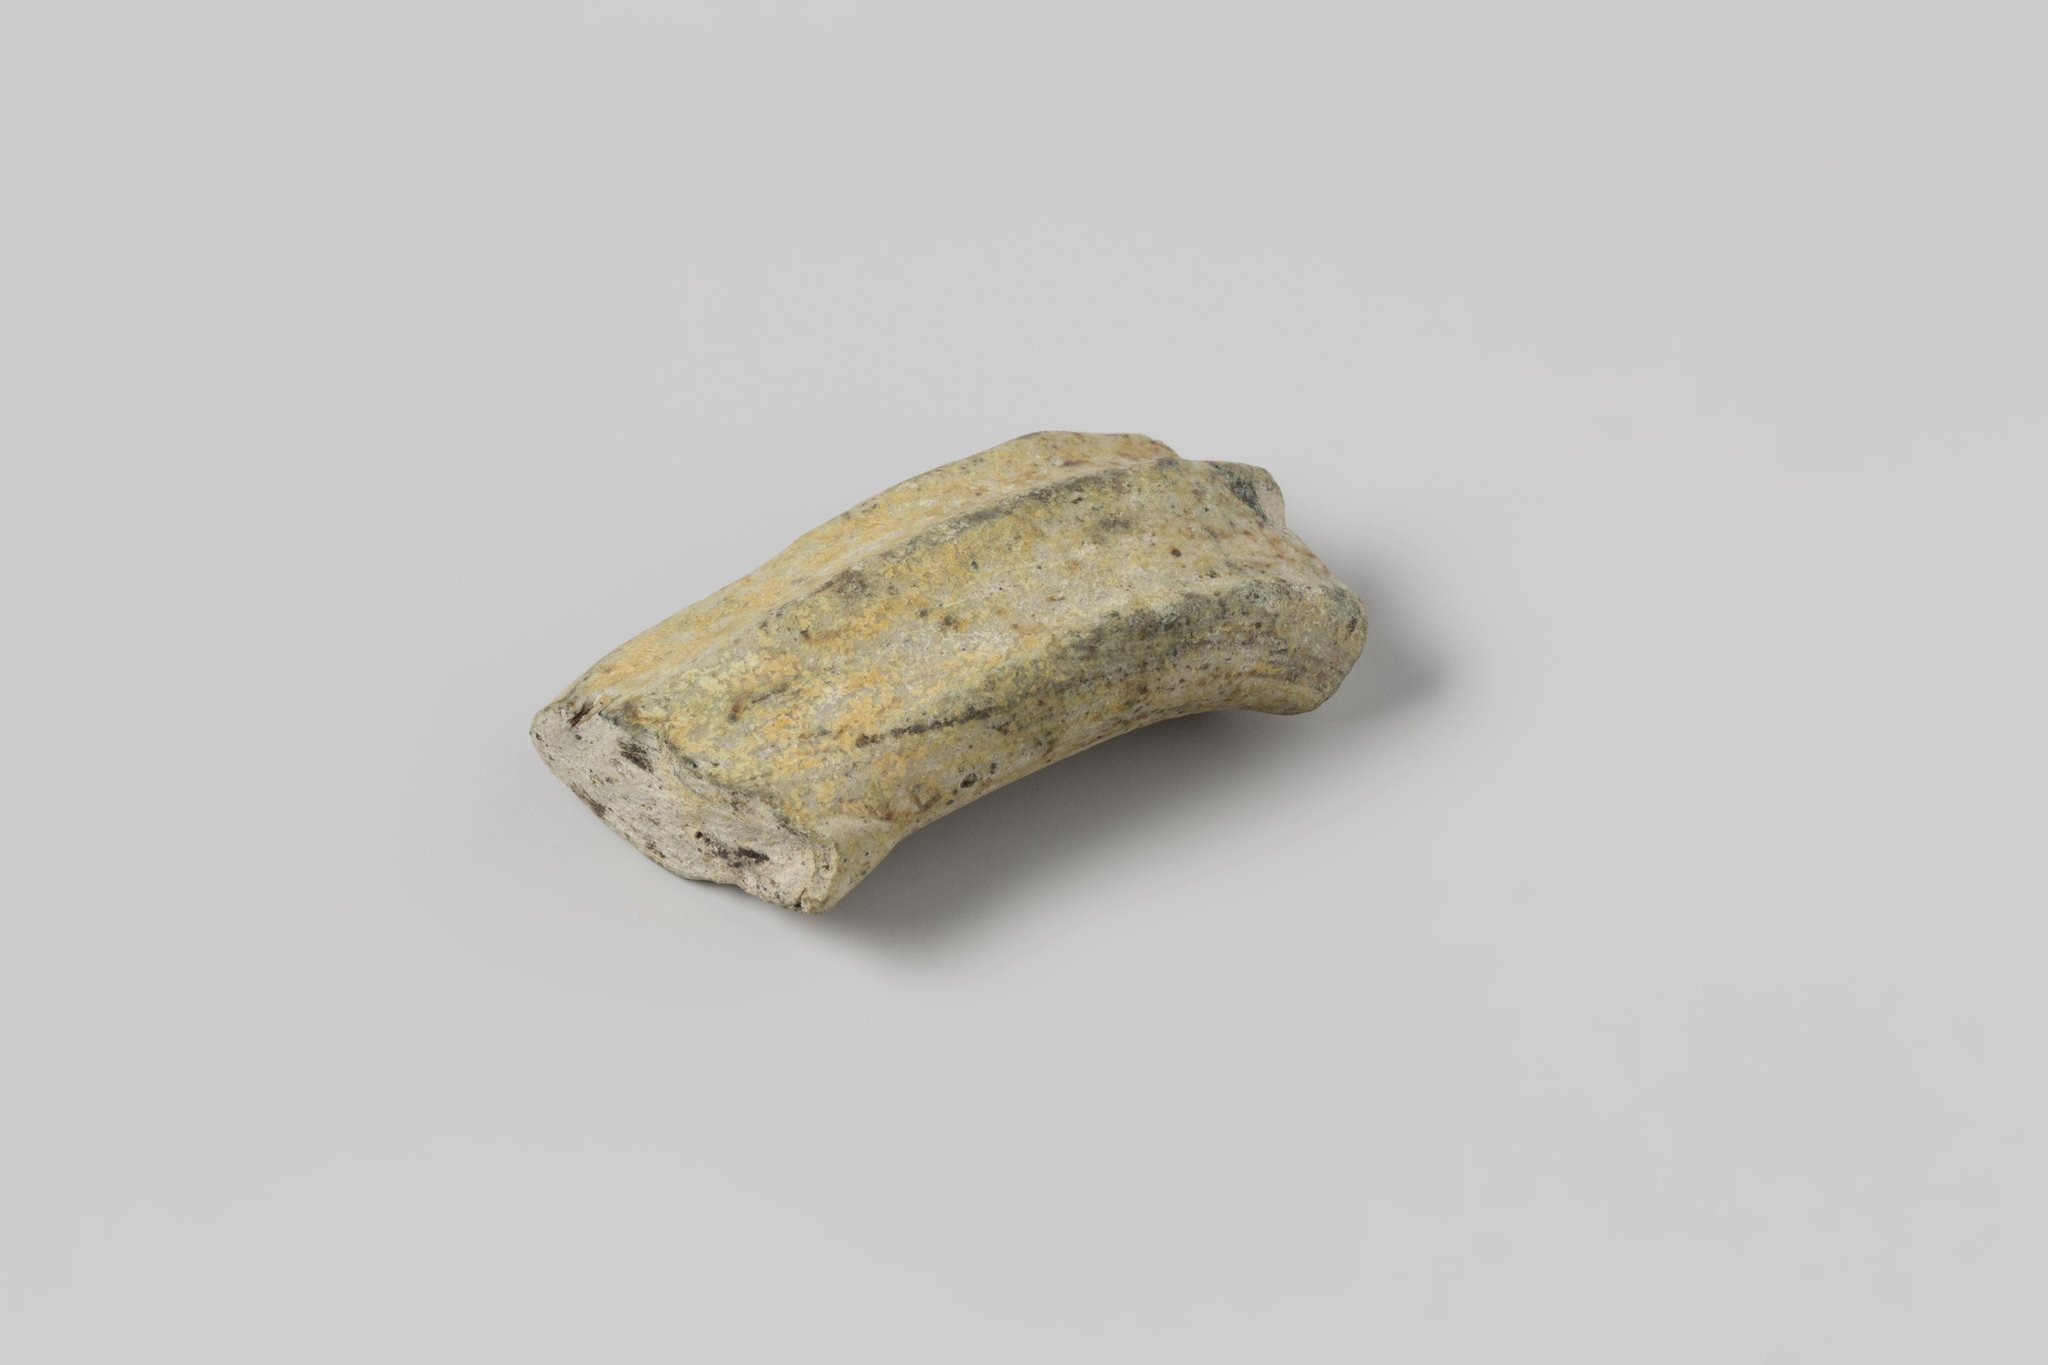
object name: ewer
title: Fragment oor van een kan uit het wrak van de Oost-Indiëvaarder Hollandia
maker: Anonymous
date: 1700-1743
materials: stoneware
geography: cologne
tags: verenigde oostindische compagnie, hollandia (schip), annet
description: Stoneware, Rhenish, Frechen-ware, jug; fragm of handle, sim. NG 1980-27H2223.